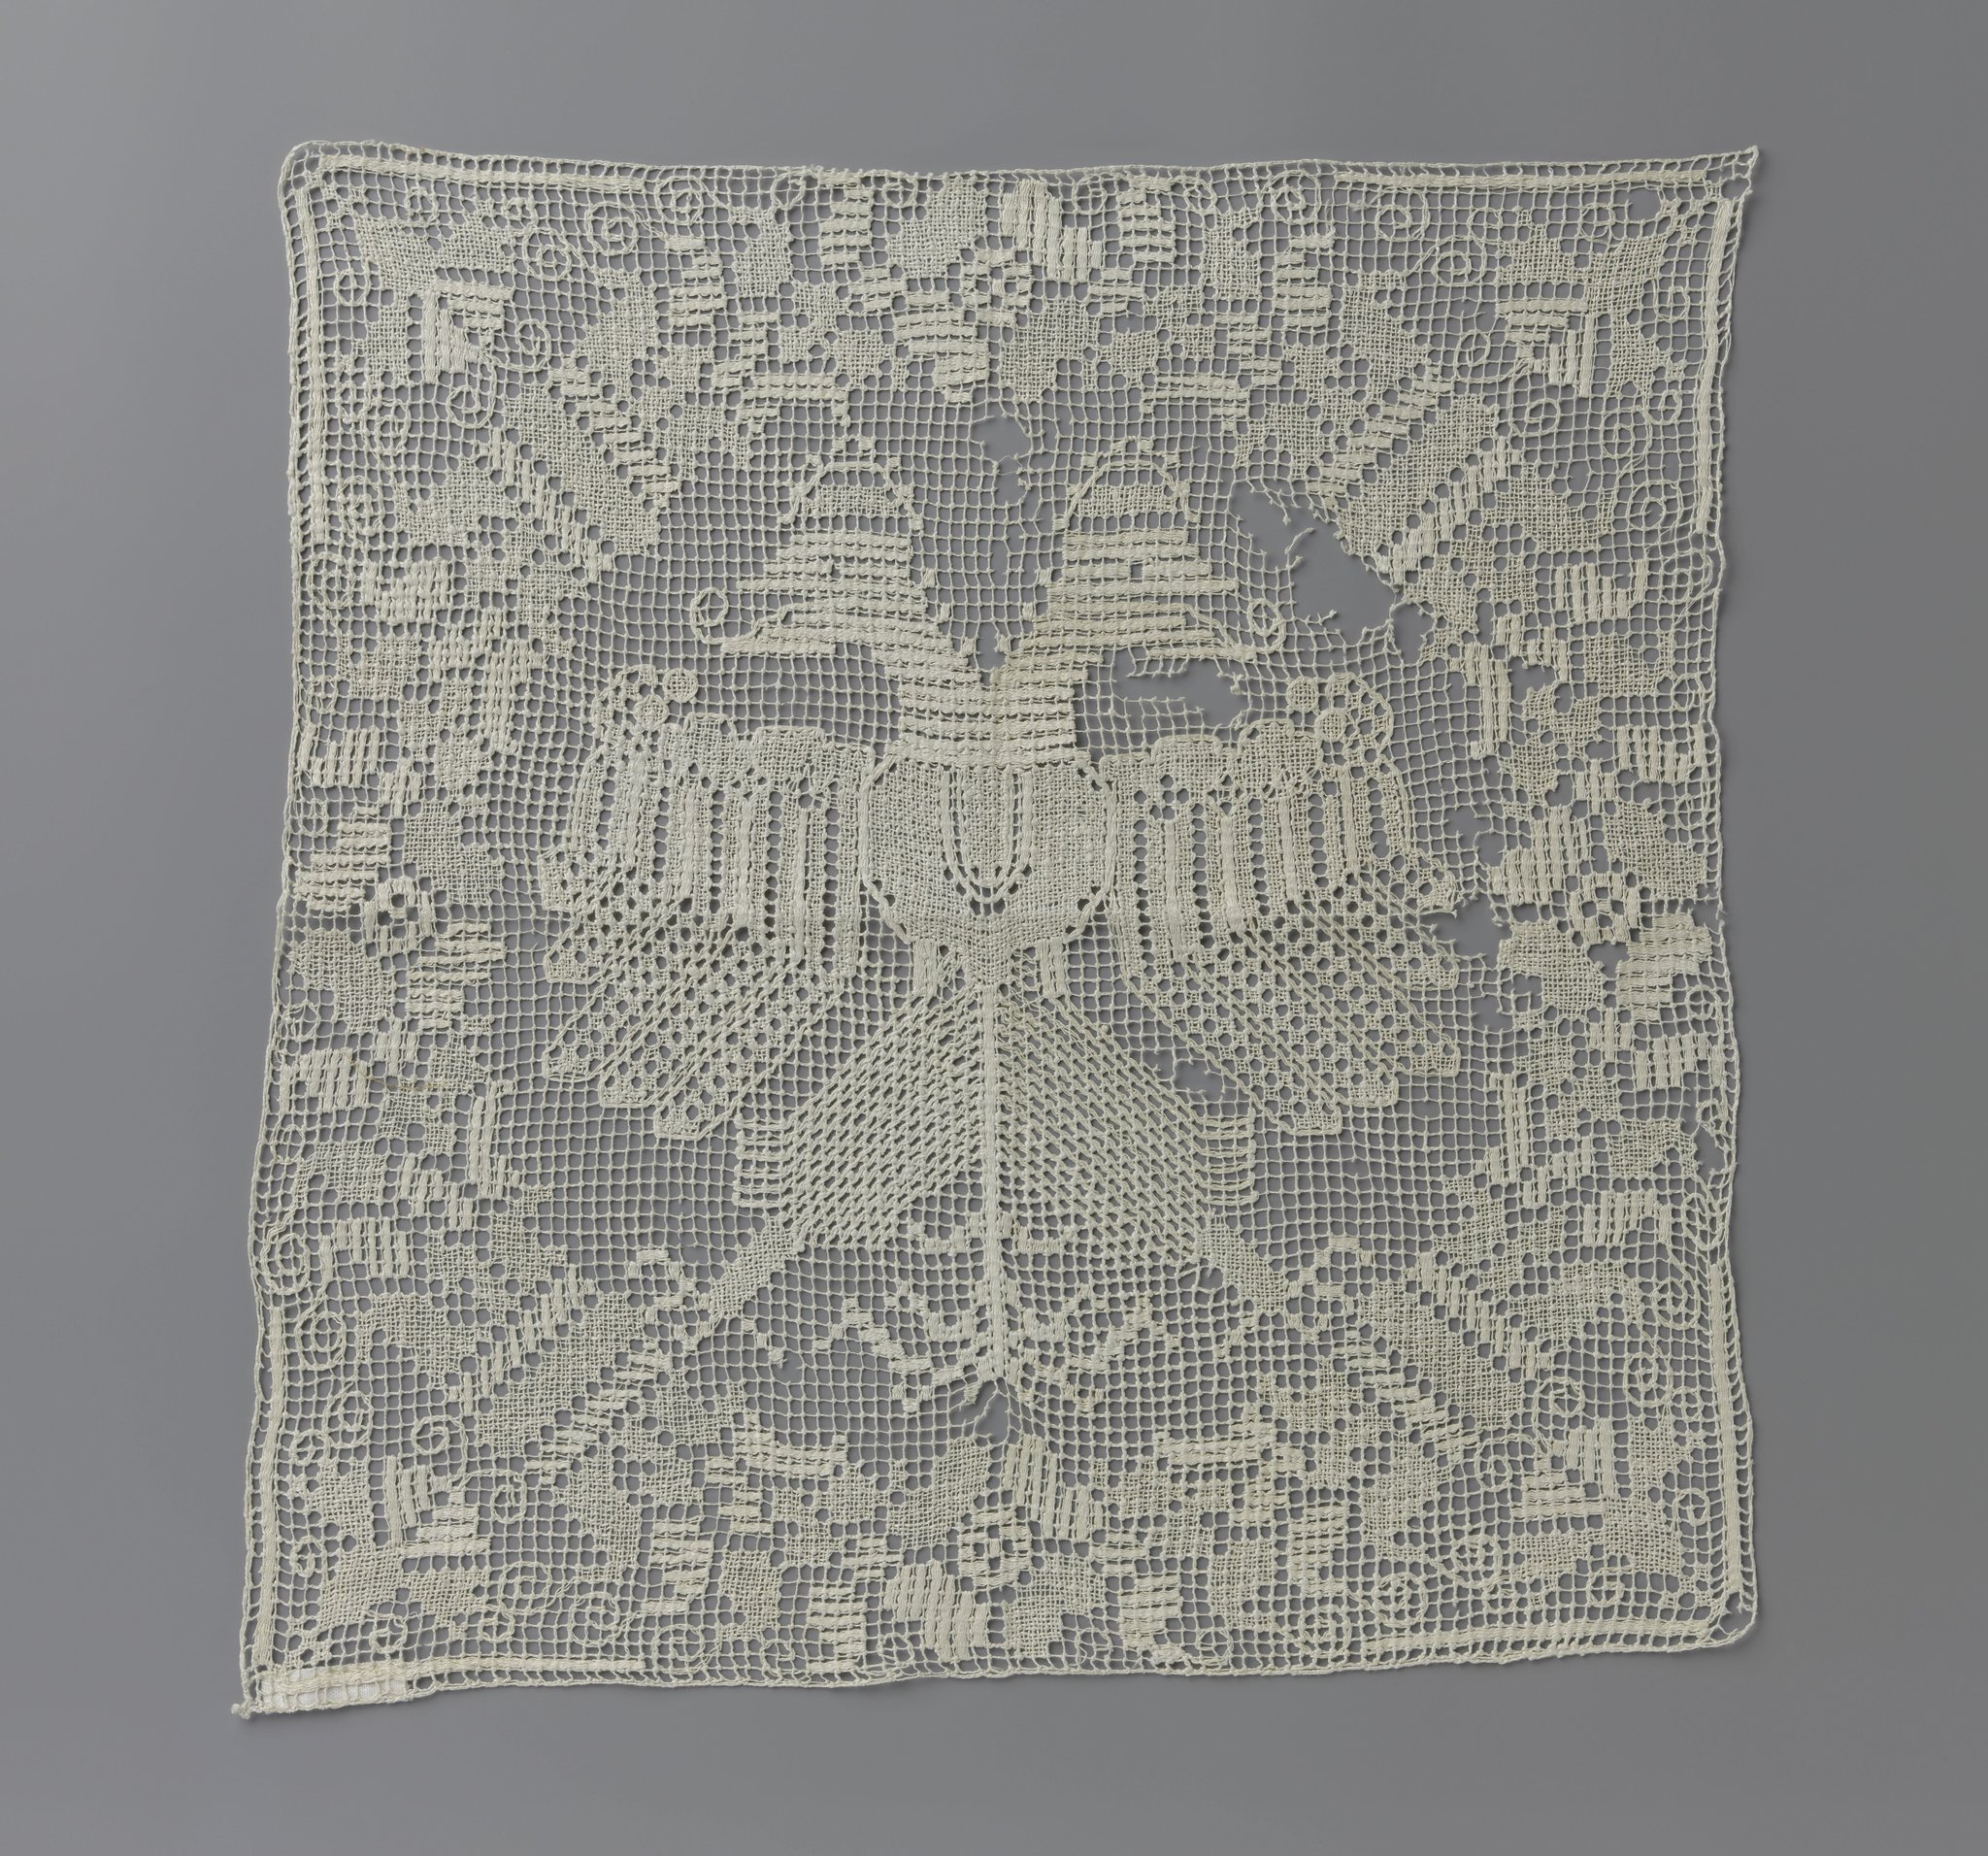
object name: mat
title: Kleedje van filetkant met gekroonde dubbele adelaar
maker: Anonymous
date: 1500-1699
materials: linen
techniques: embroidered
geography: germany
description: Kleedje van naturelkleurig kantborduurwerk: filetkant. Patroon met een gekroonde dubbele adelaar in een krans van gestileerde rozen op een geknoopt netwerk met vierkante mazen. Hoekvullingen met gestileerde anjers. De motieven zijn gemaakt in de stopsteek en de linnenstopsteek.